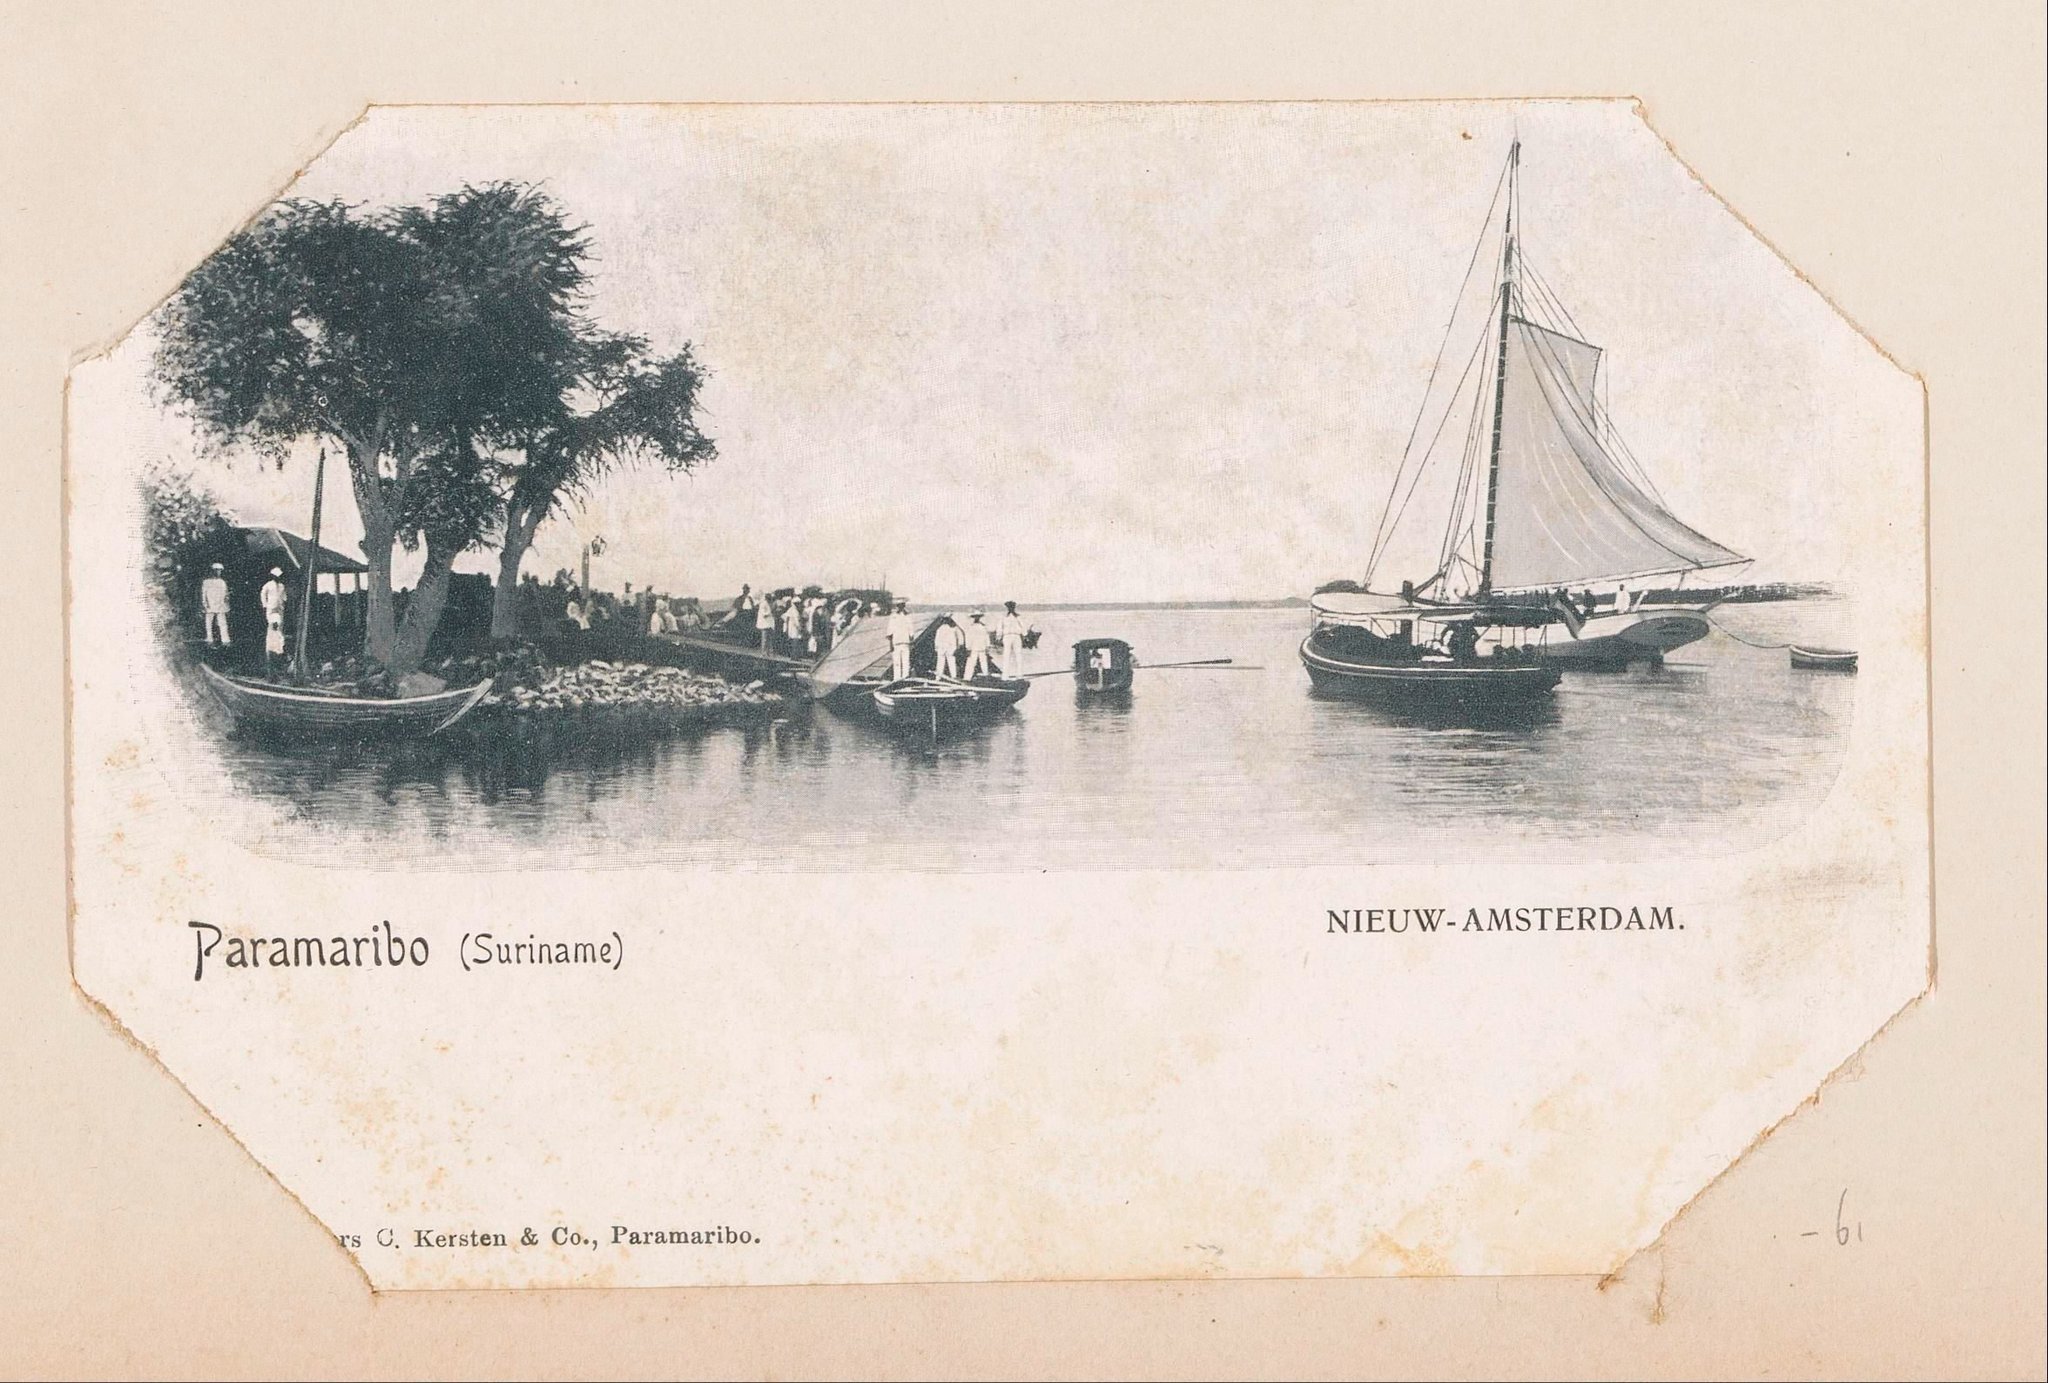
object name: ansichtkaart, prentbriefkaart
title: Landingsplaats bij Nieuw-Amsterdam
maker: Anonymous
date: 1900-1910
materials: cardboard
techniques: autotype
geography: paramaribo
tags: pier, quay, wharf, suriname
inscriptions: serial number: ‘No. 38. Uitgevers C. Kersten & Co., Paramaribo’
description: Landingsplaats bij Nieuw-Amsterdam, mensen op de kade, boten op het water. Onderdeel van een verzameling van 68 briefkaarten uit Suriname, bijeengebracht in een album als aandenken aan een verblijf in Suriname in september 1911.